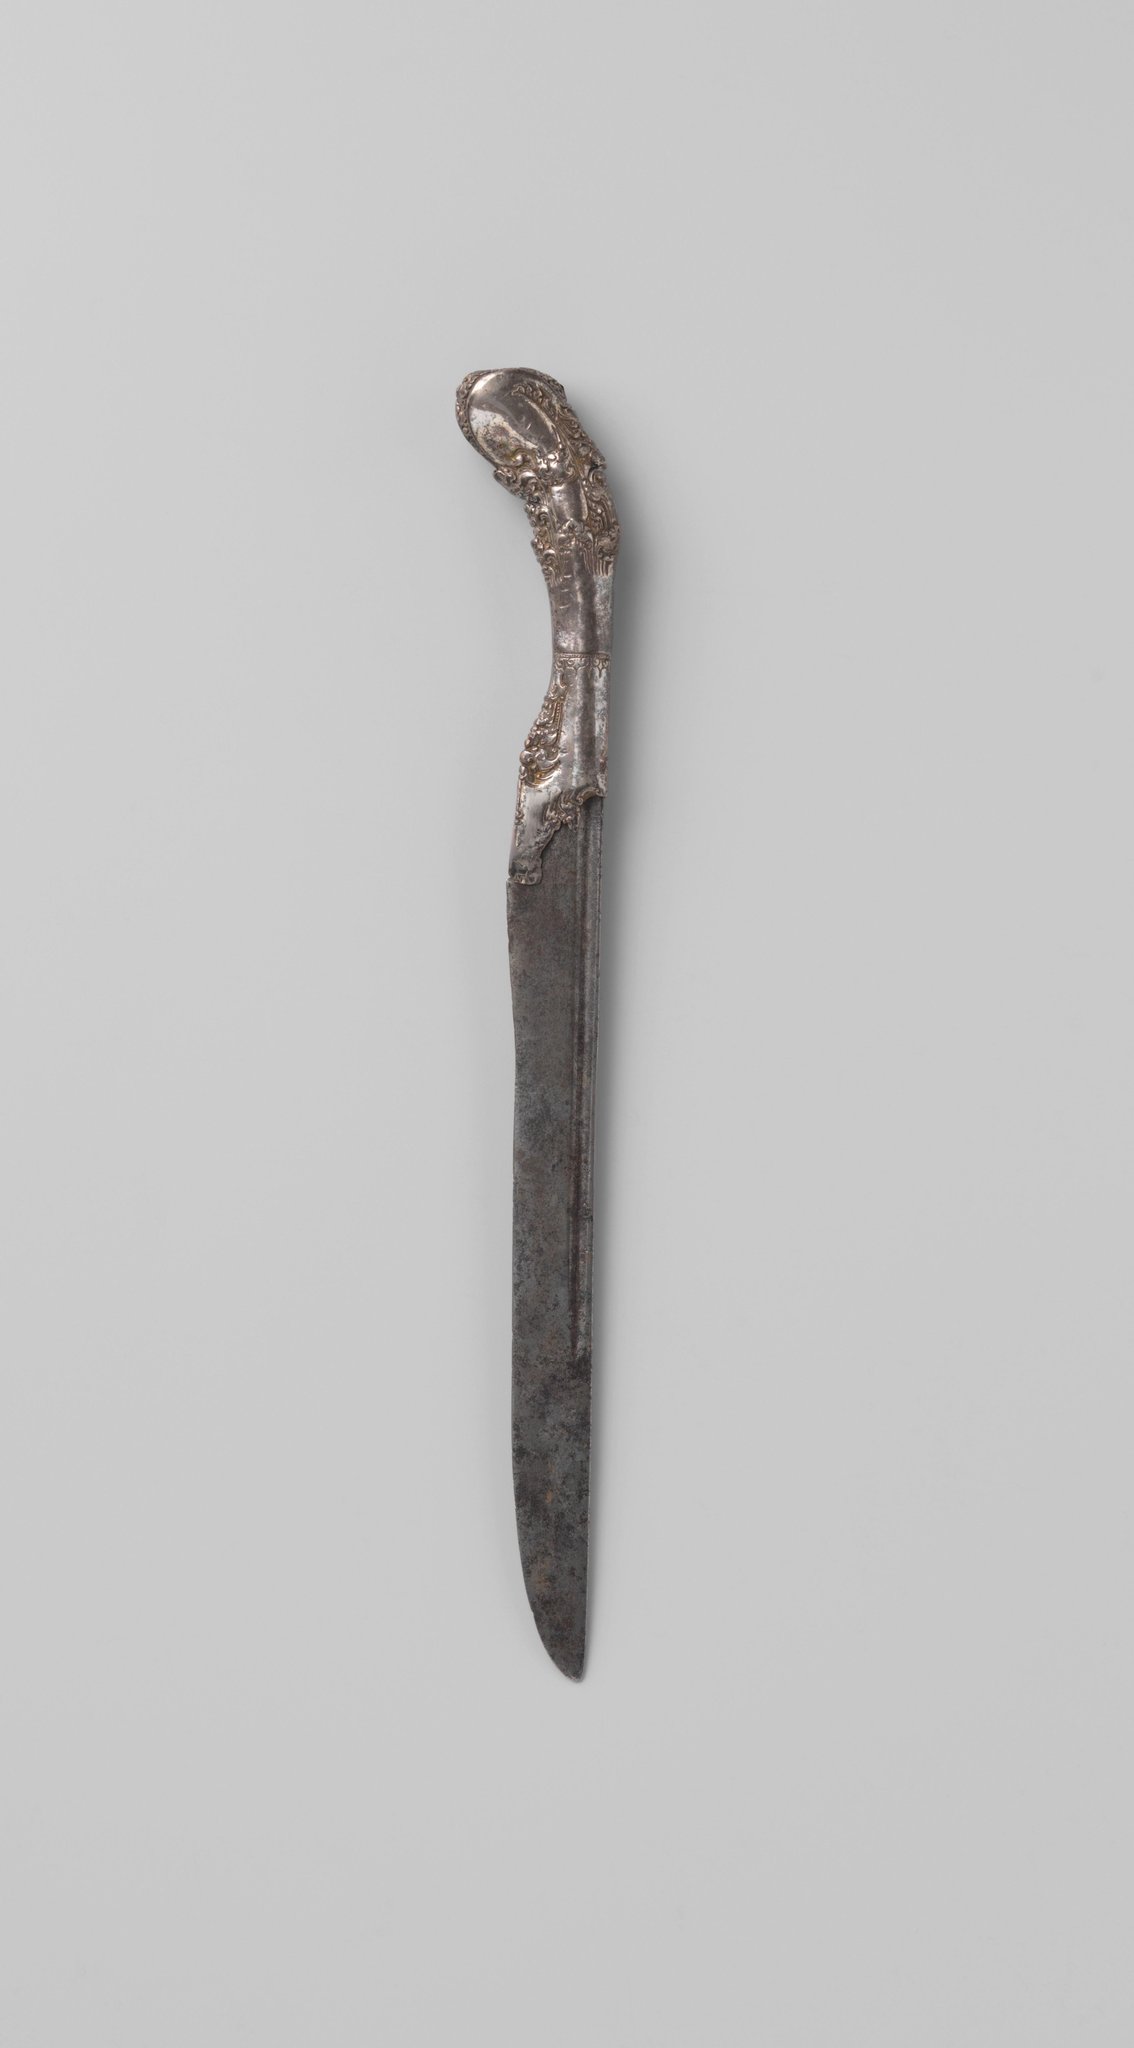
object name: knife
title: IJzeren mes met zilveren handvat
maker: Anonymous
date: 1775-1800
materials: iron, silver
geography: sri lanka